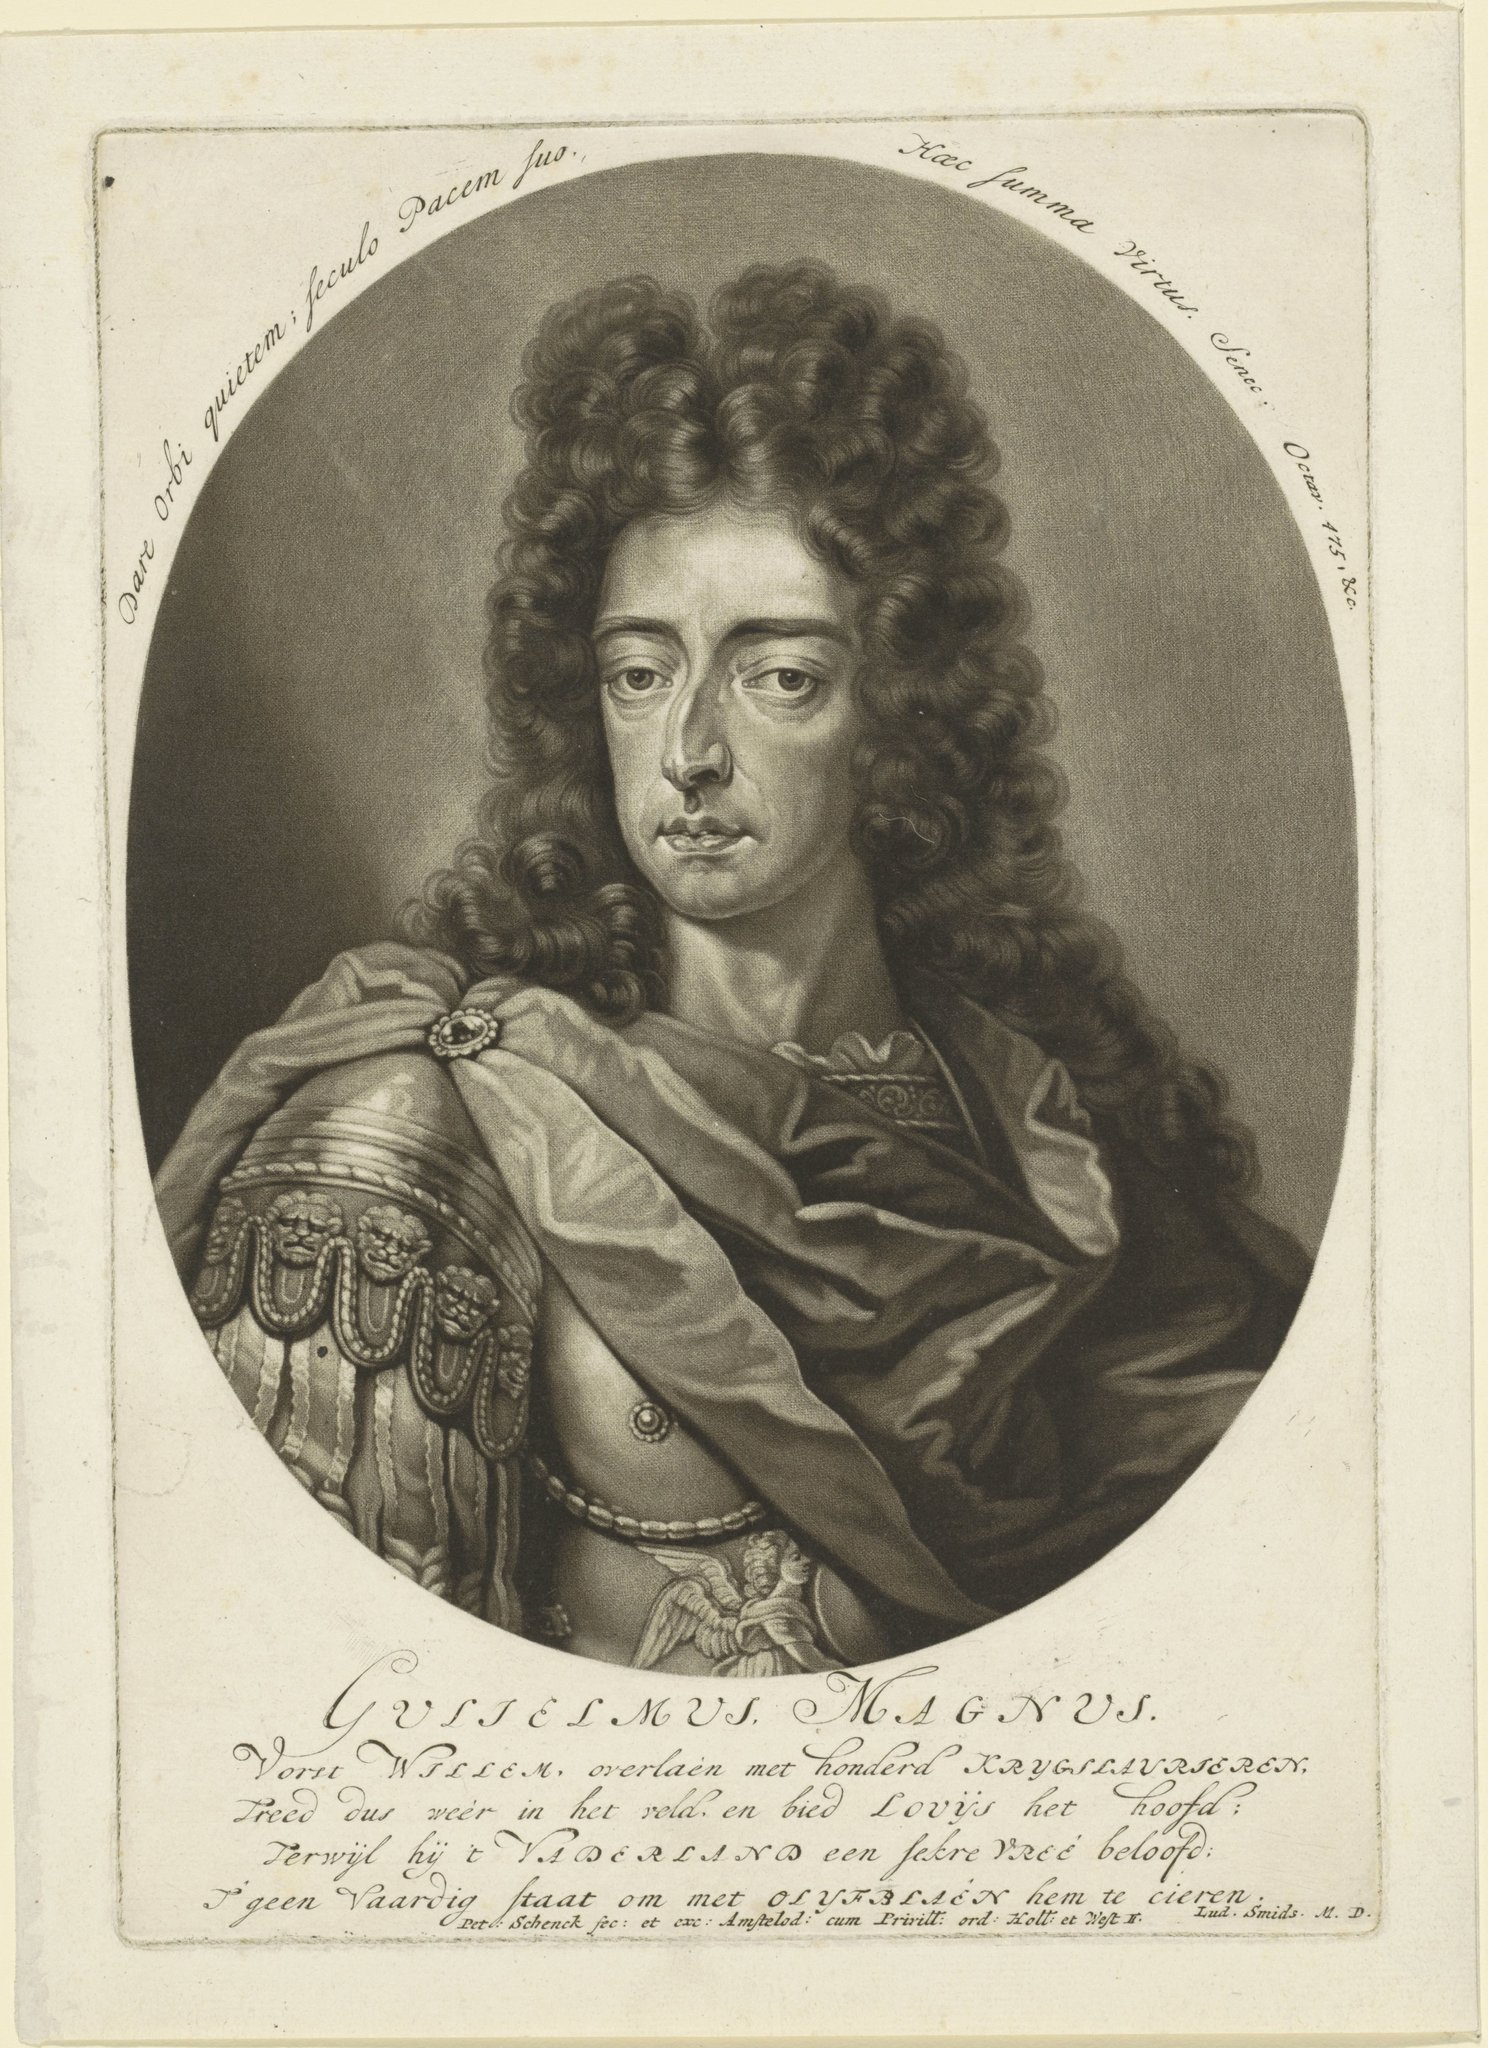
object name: print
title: Portret van Willem III, prins van Oranje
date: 1688-1711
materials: paper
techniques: mezzotint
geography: amsterdam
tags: the hague, william iii (prince of orange and king of england, scotland, and ireland)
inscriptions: collector's mark: Lugt 963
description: De hier vermelde titel verwijst naar de hoogst verkregen titel van de geportretteerde, niet per se naar de titel die de geportretteerde op deze voorstelling draagt.